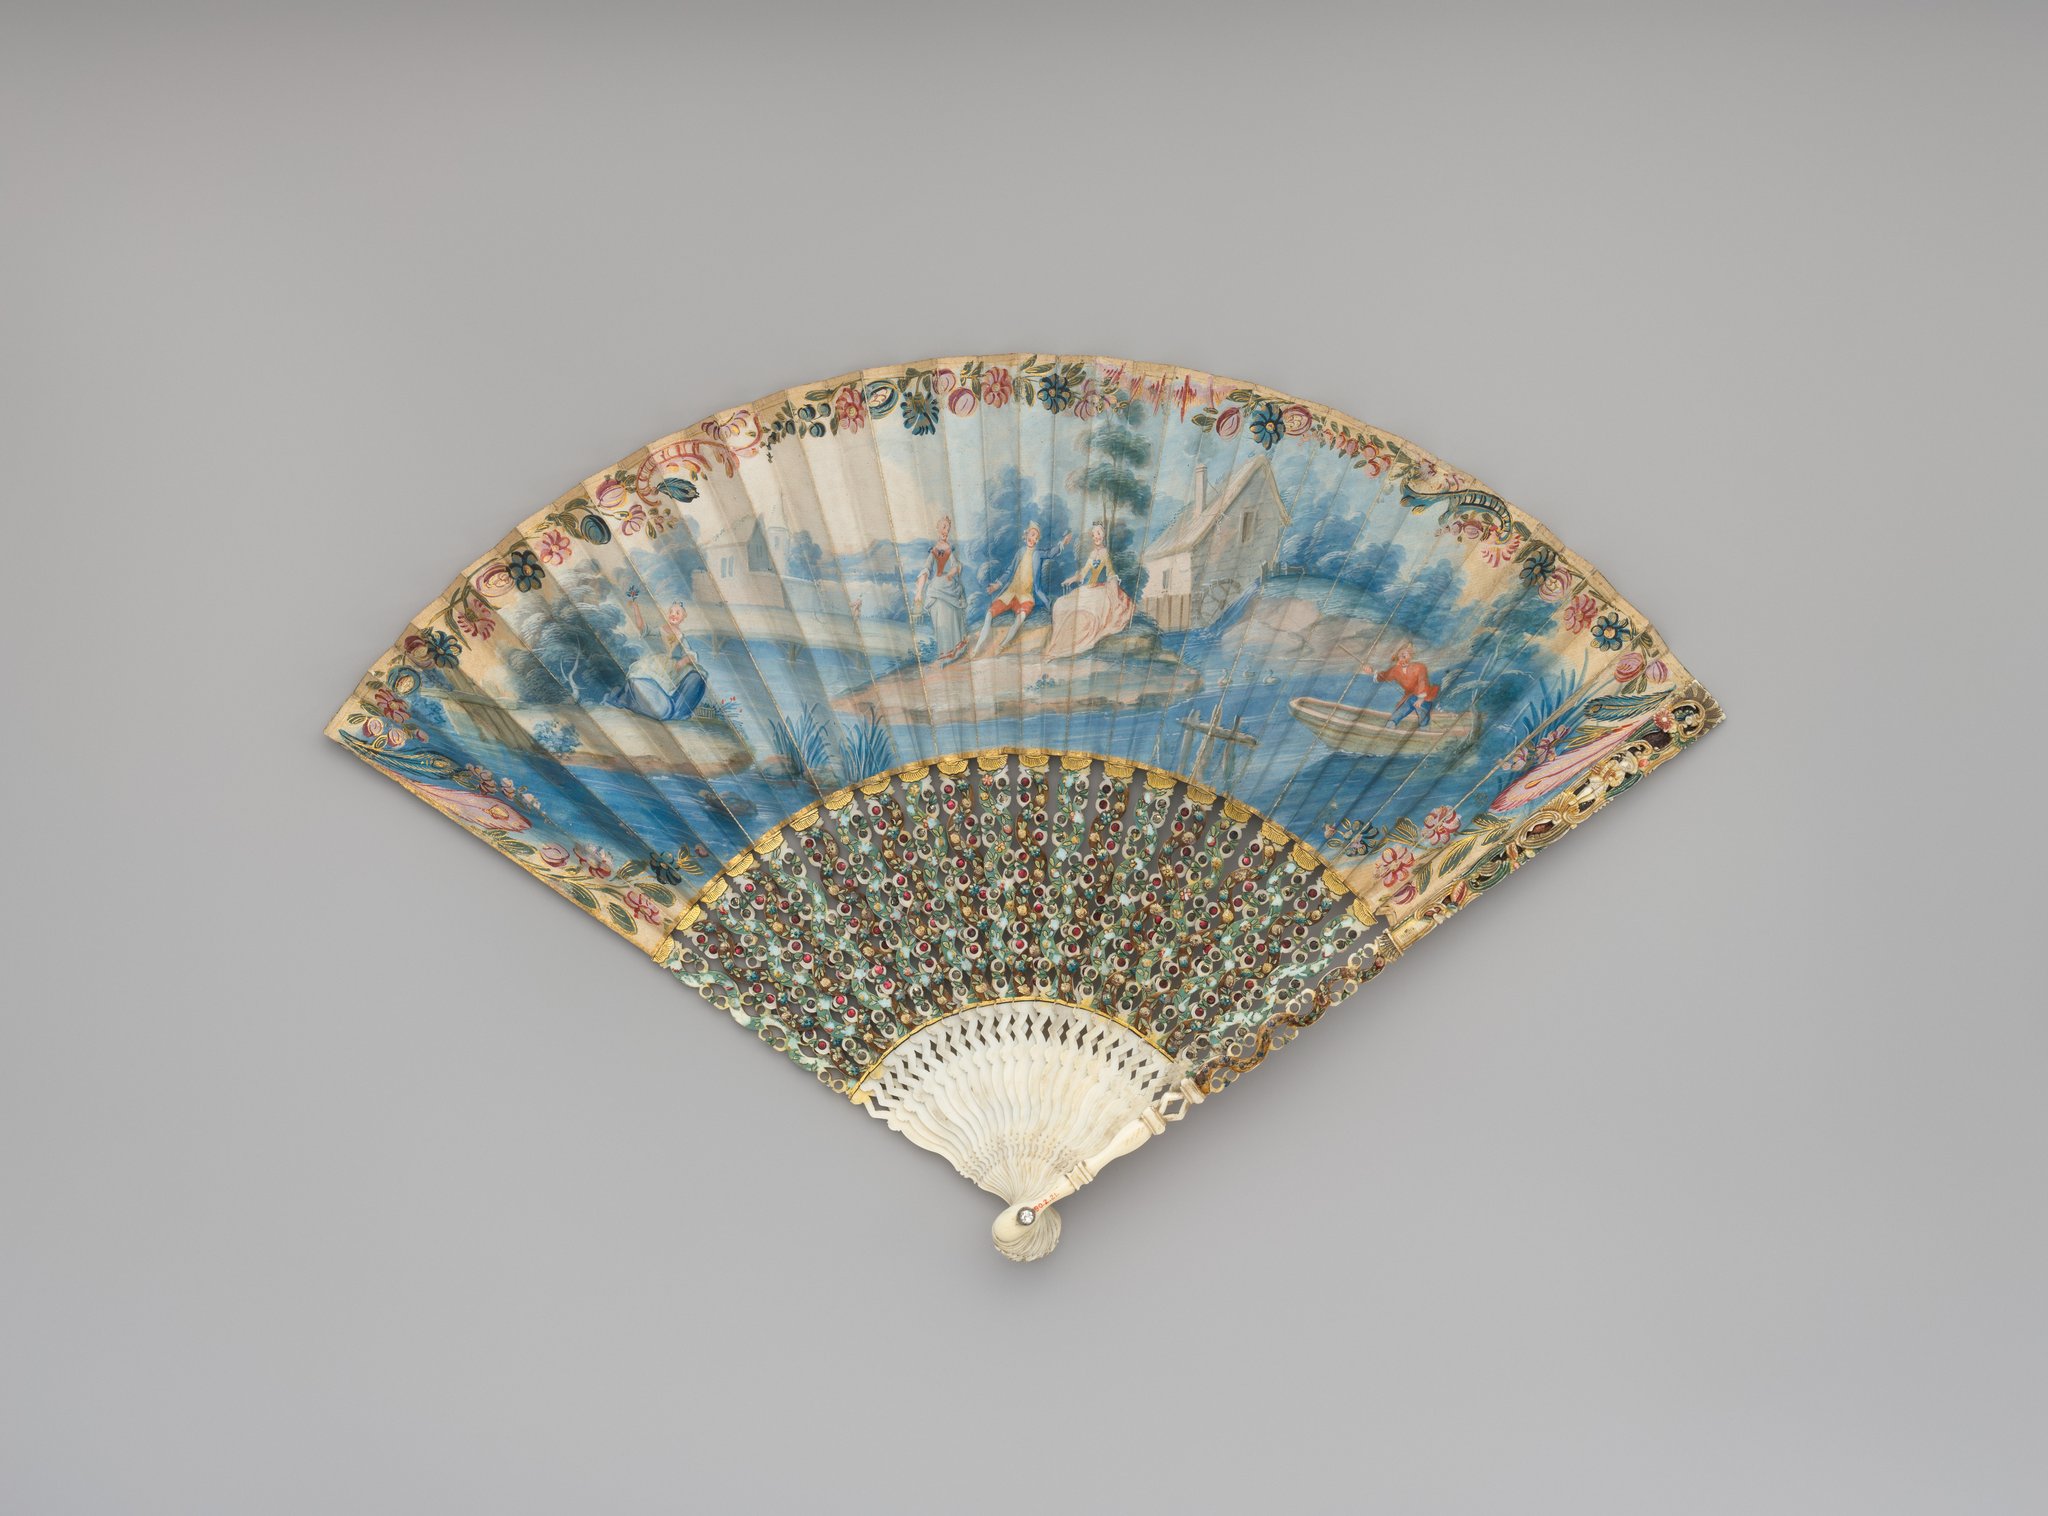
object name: fan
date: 1750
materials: ivory, paper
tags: men,women,boats